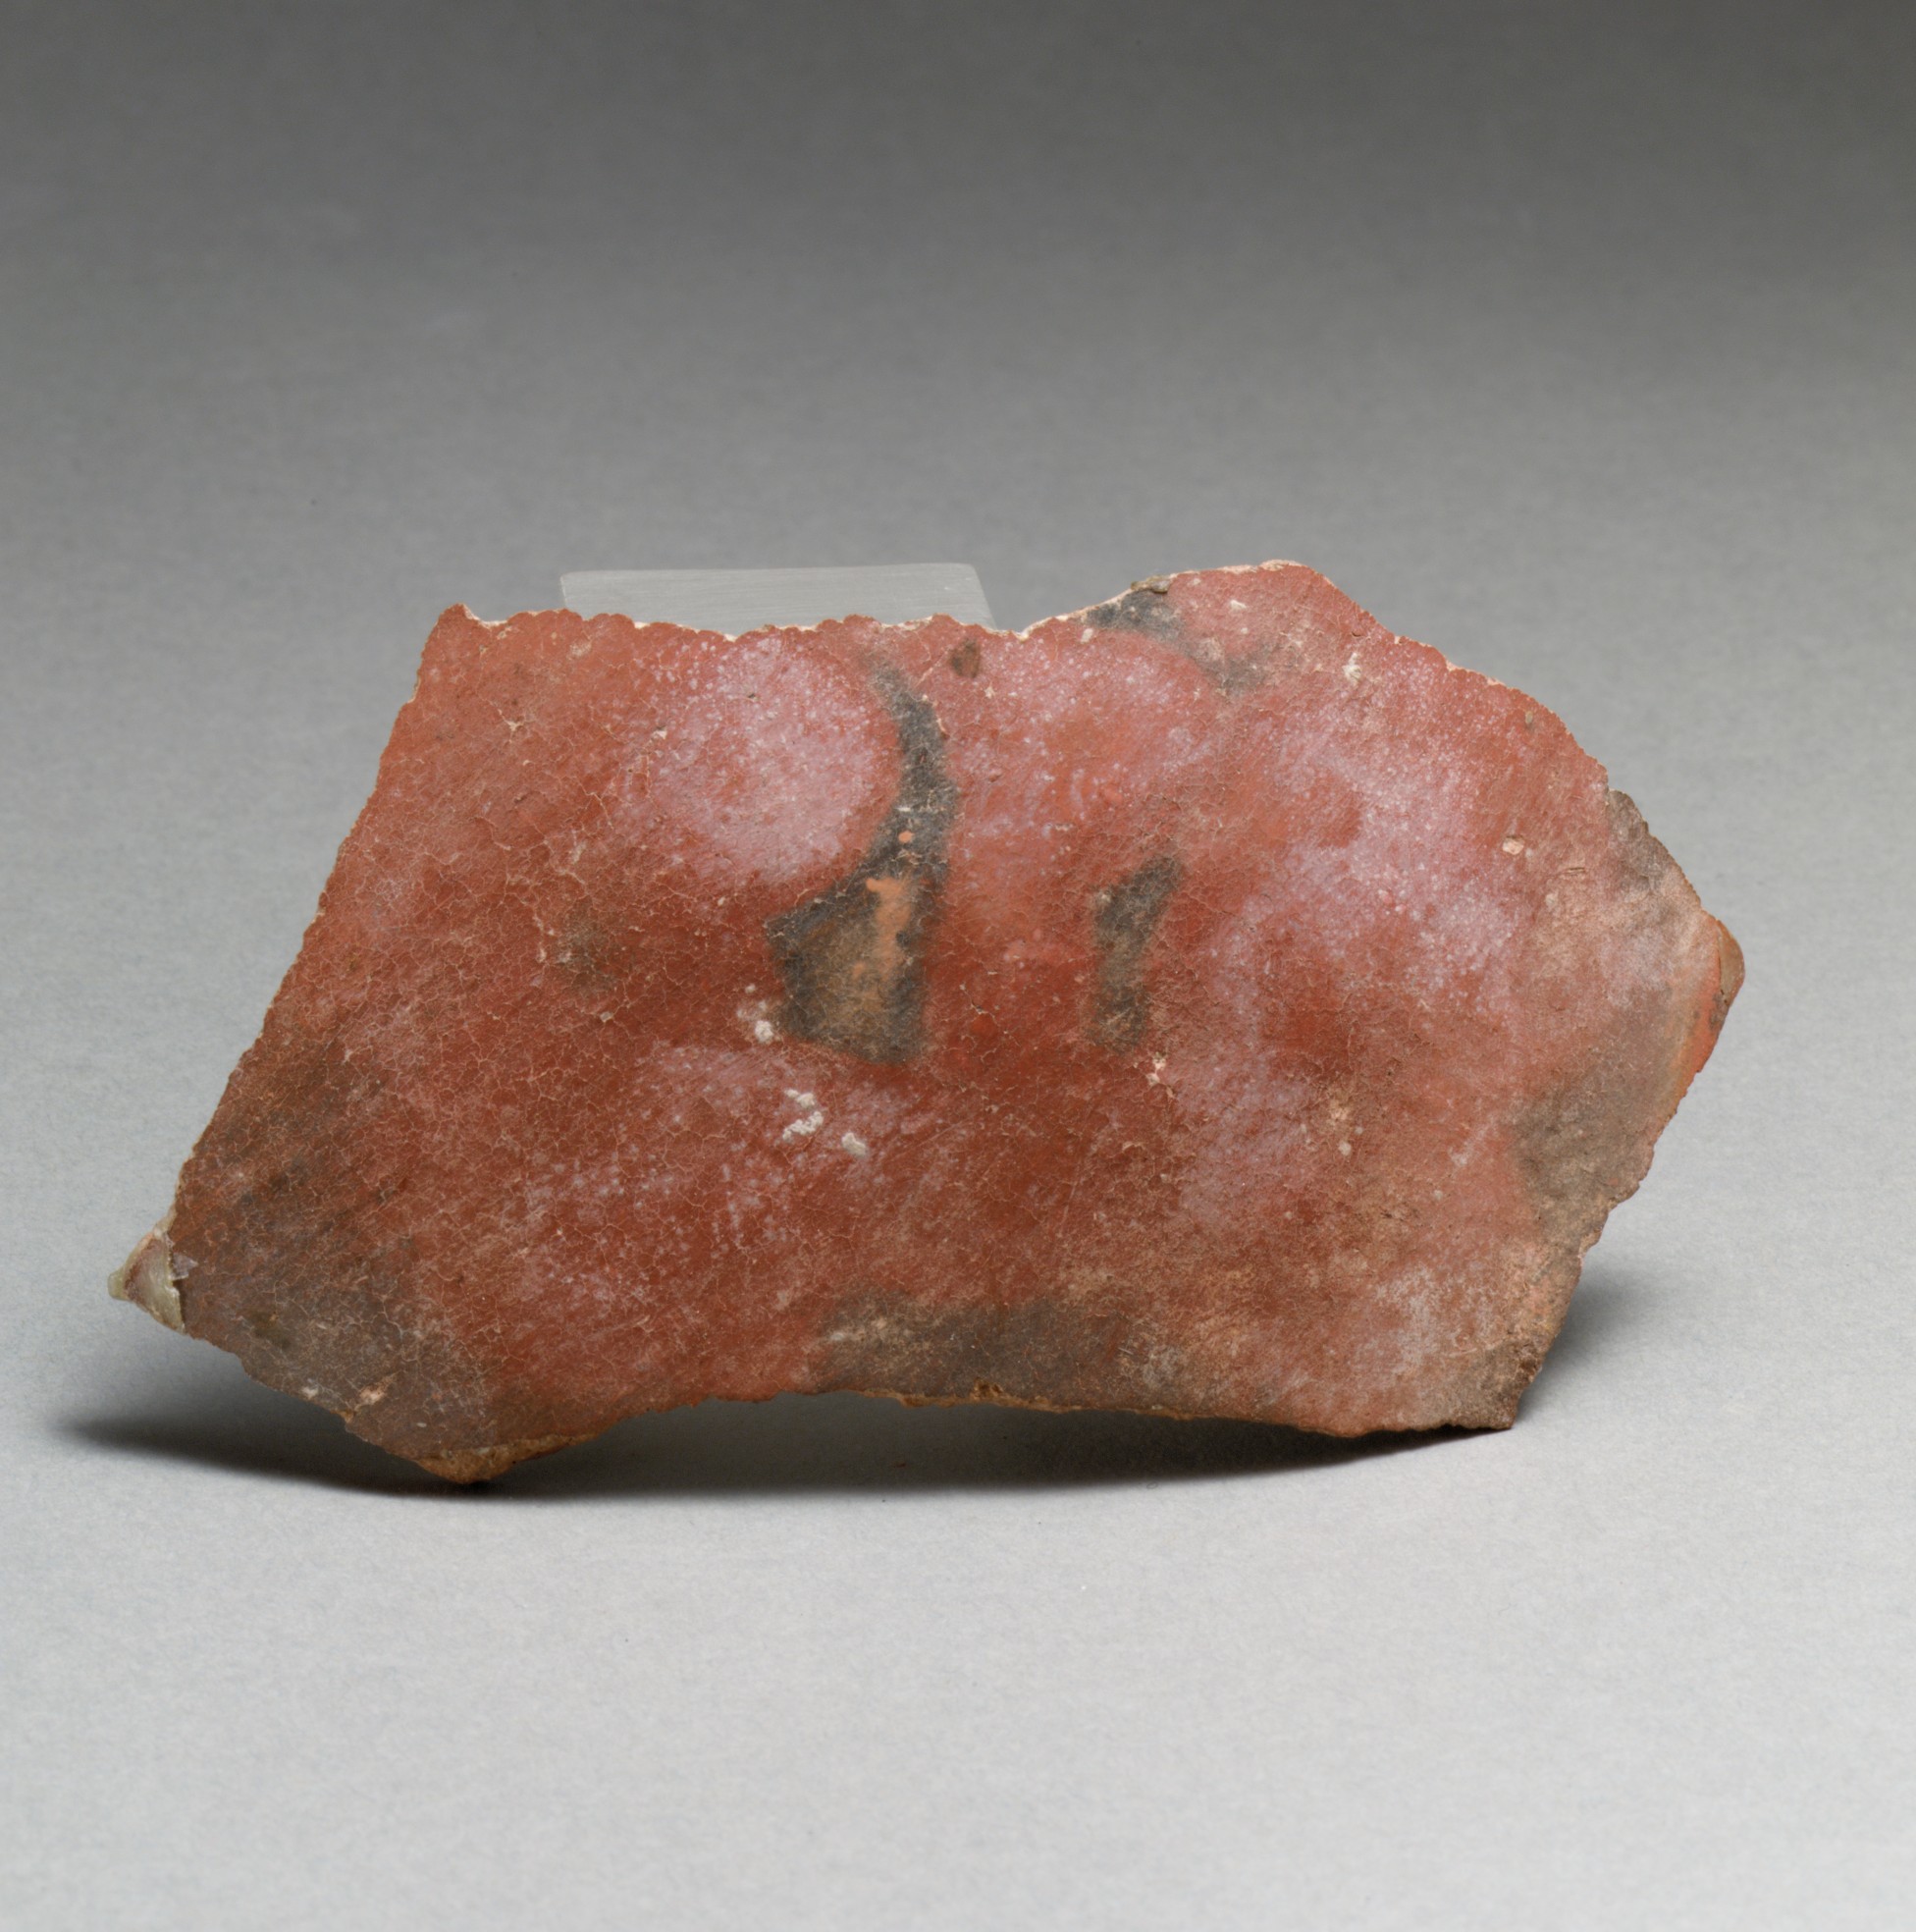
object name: vase fragment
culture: minoan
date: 2600-2000 BCE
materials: terracotta